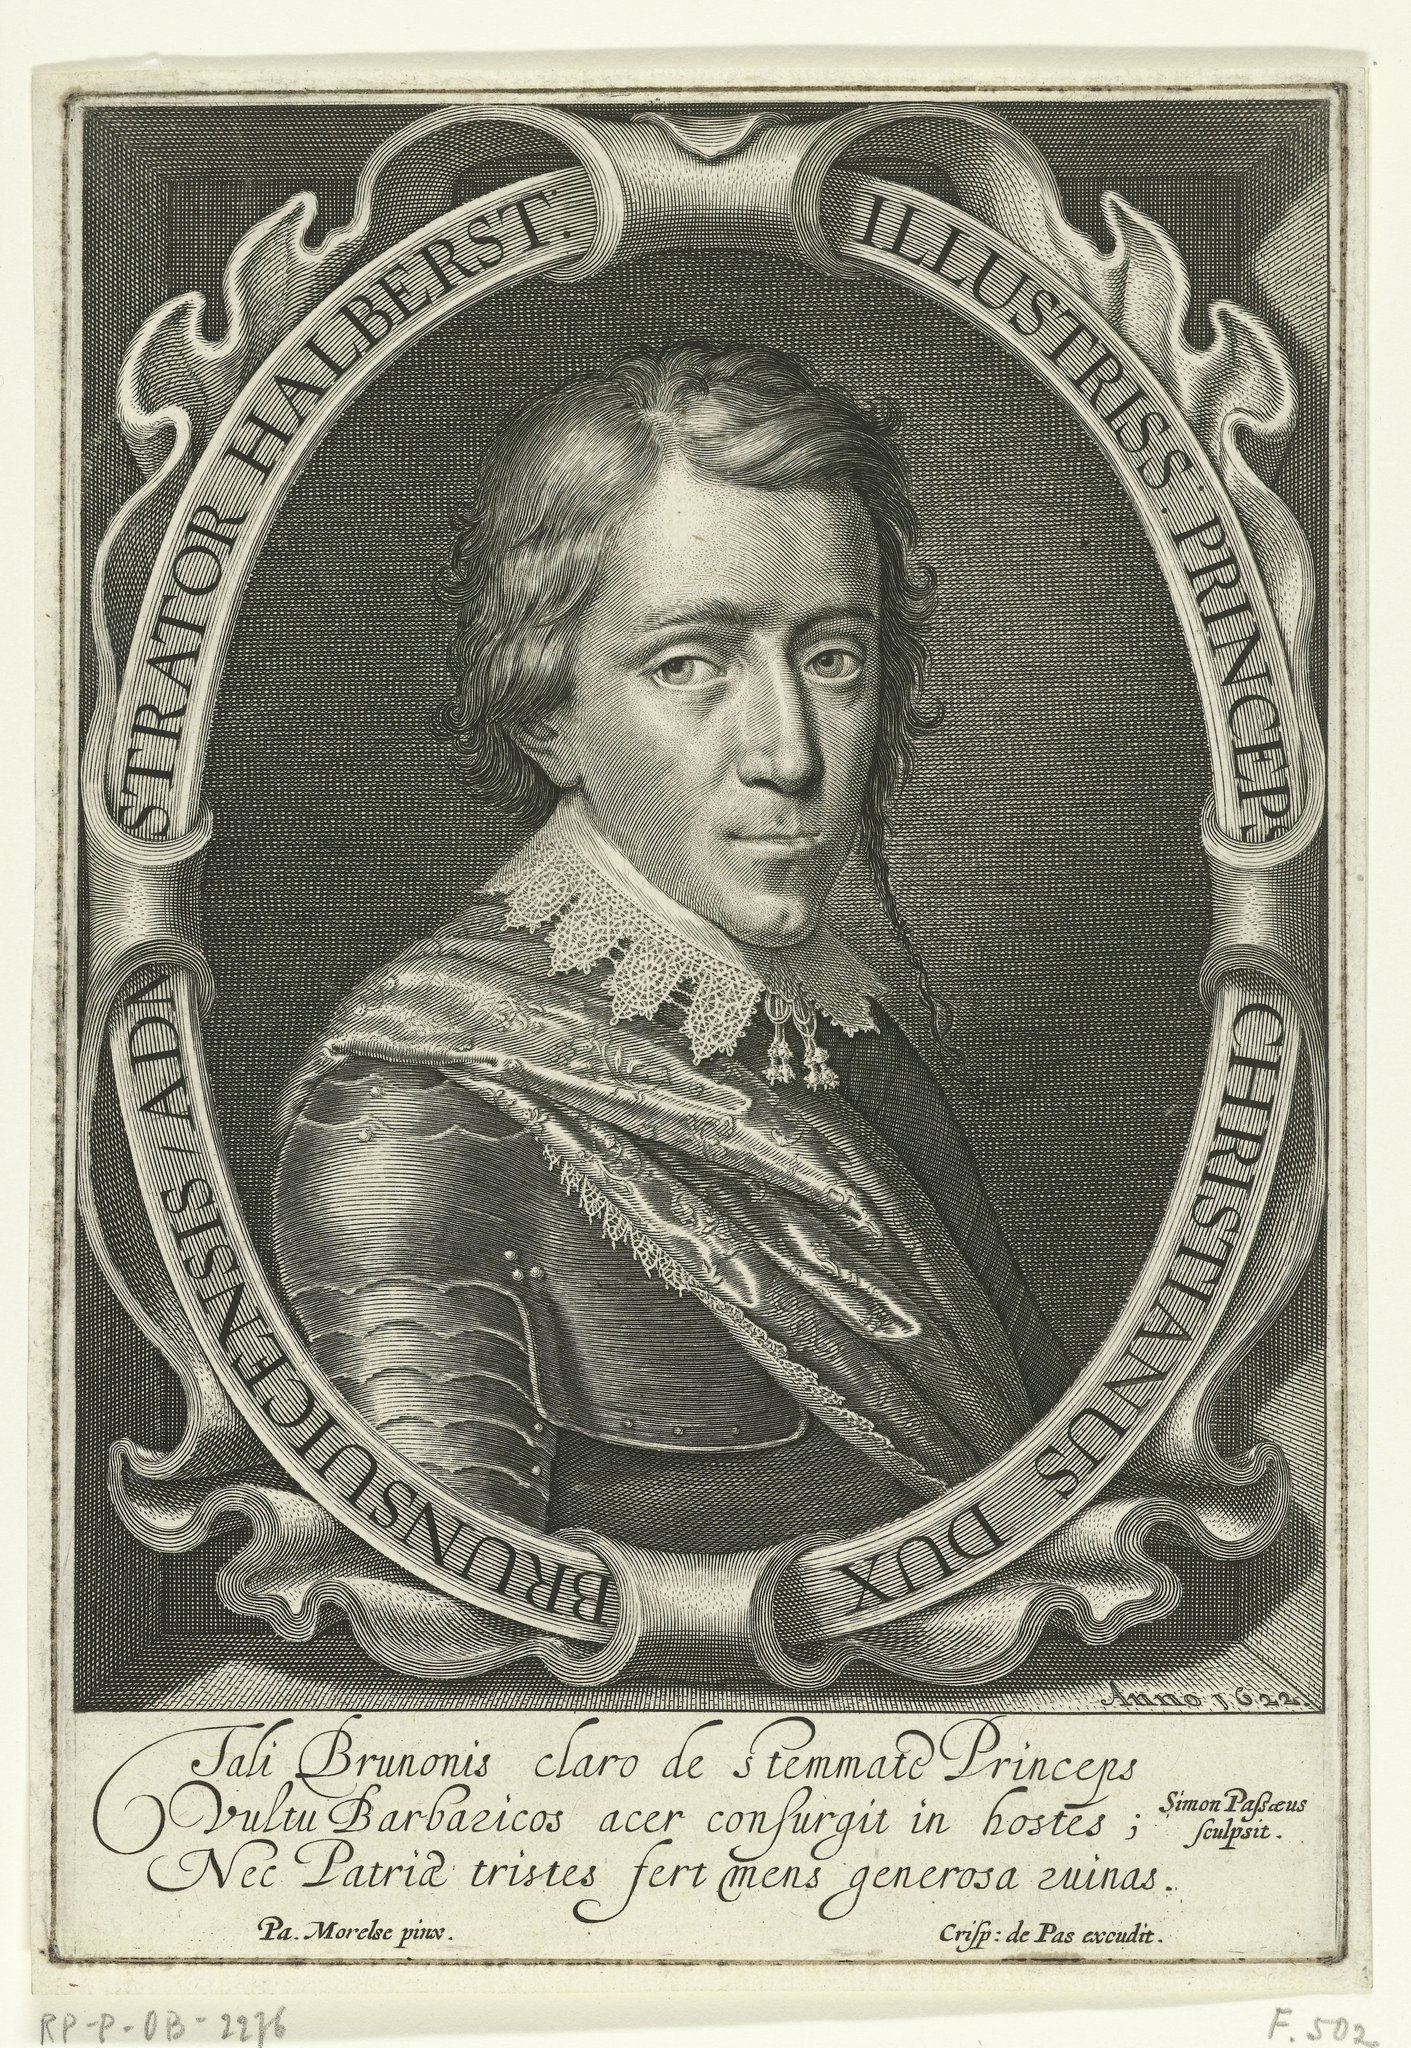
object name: print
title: Portret van Christiaan, hertog van Brunswijk-Wolfenbüttel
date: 1622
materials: paper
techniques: engraving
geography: london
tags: groningen, wolfenbüttel, bisschop, christiaan (ii) hertog van brunswijk-wolfenbüttel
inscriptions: date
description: Portret van Christiaan, hertog van Brunswijk-Wolfenbüttel, ook wel "Dolle Hertog" genoemd. Hij was militair leider en Lutherse beheerder van het prinsbisdom Halberstadt. In het randschrift van de omlijsting de naam en functie van de geportretteerde in het Latijn. In de marge een drieregelig onderschrift in het Latijn.